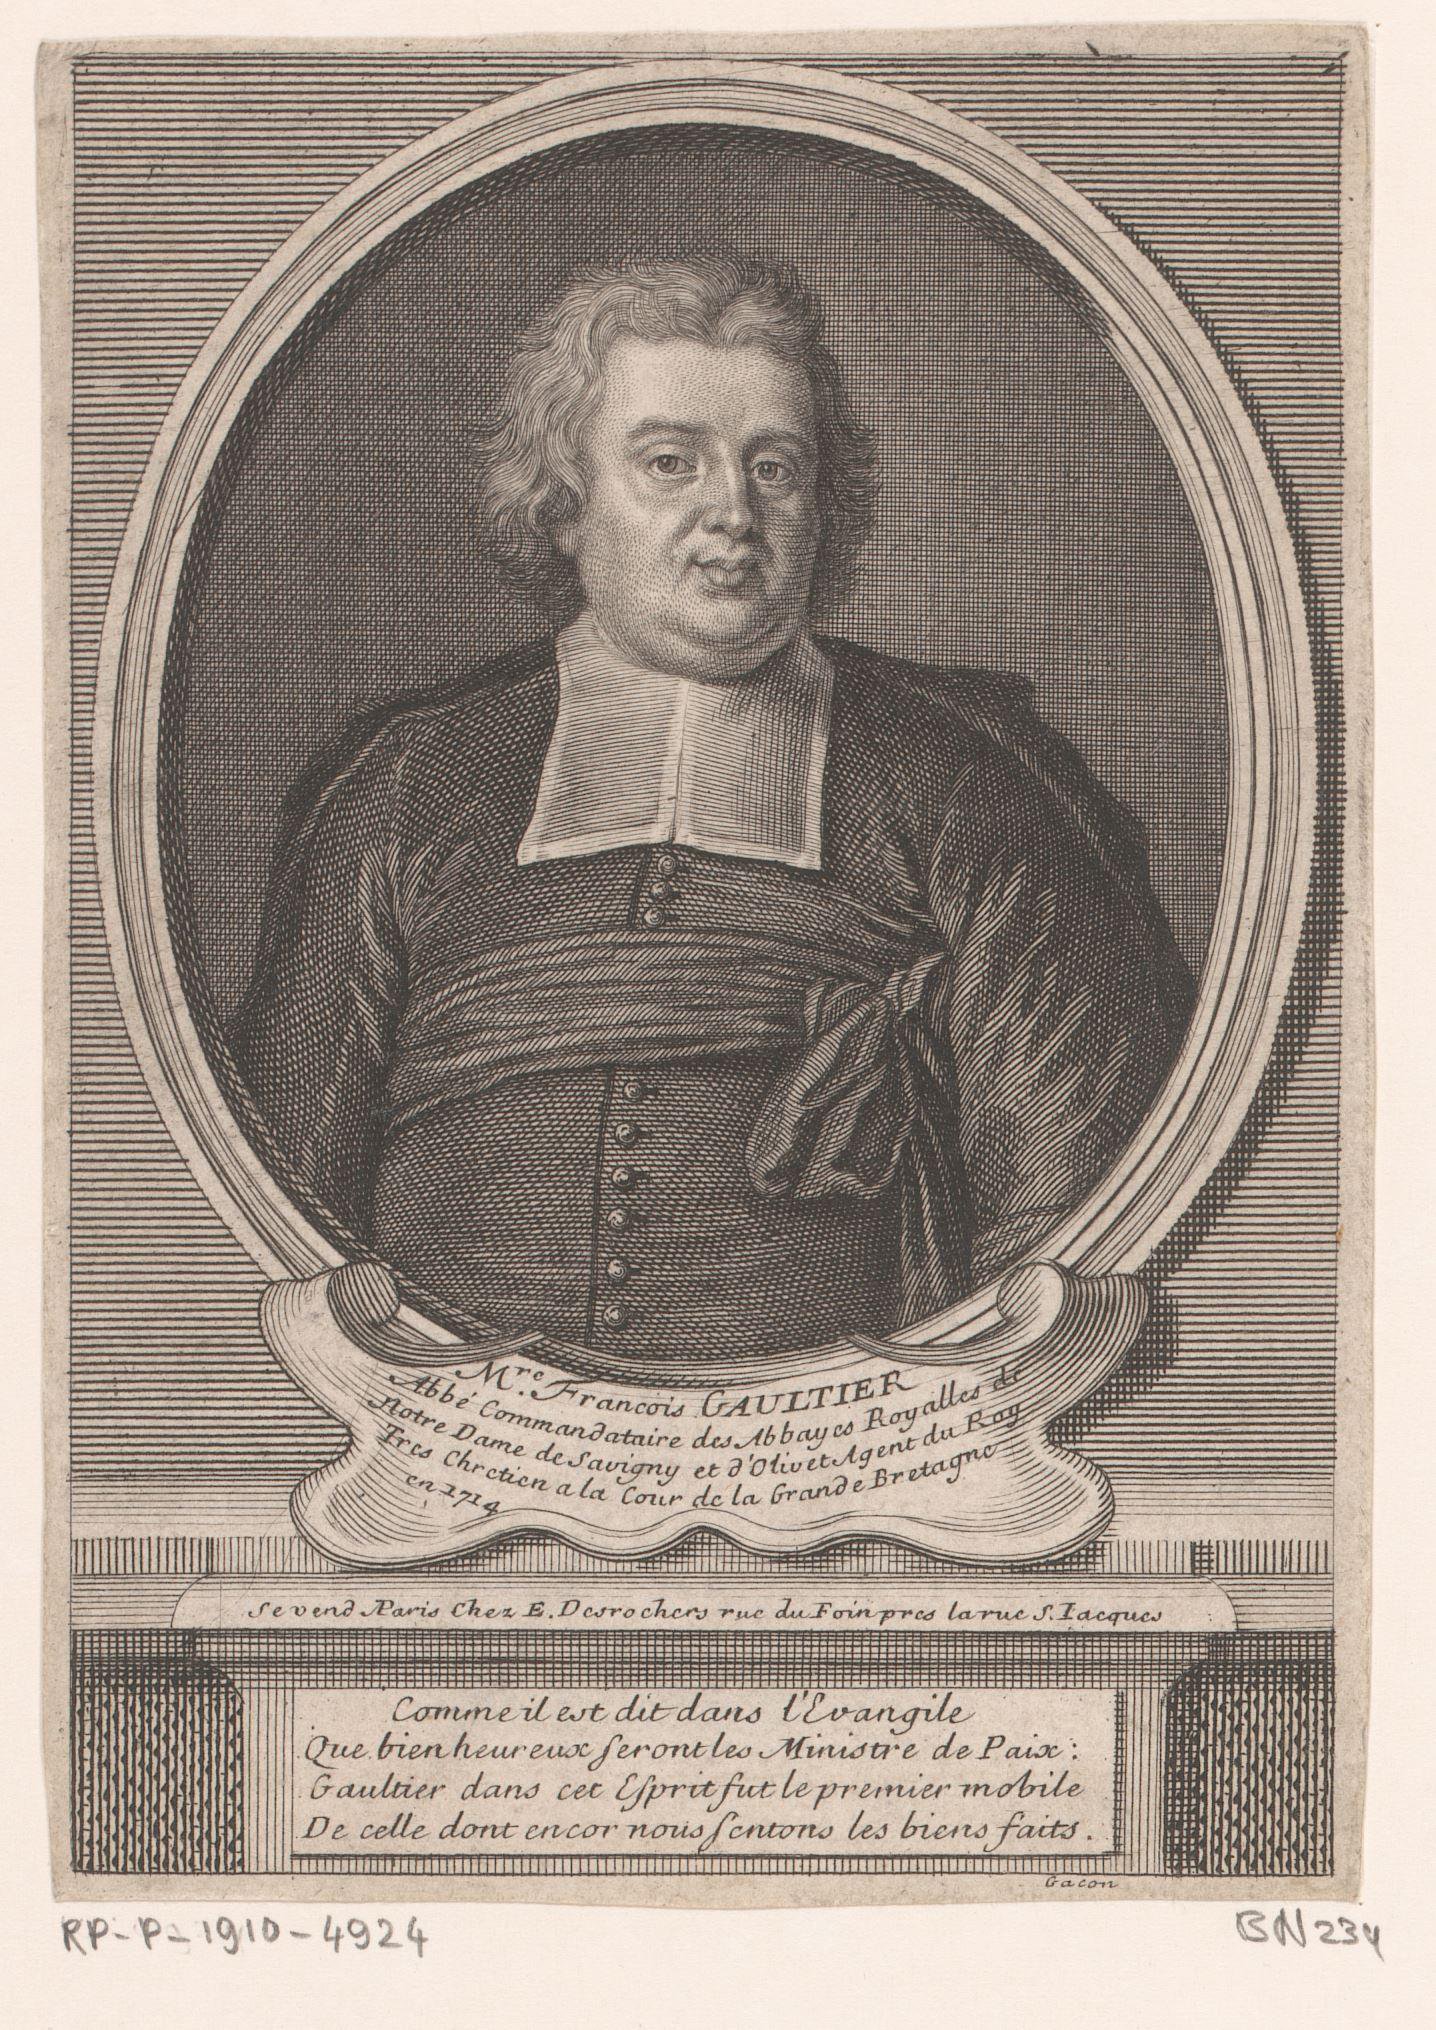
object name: print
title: Portret van François Gaultier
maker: étienne desrochers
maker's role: print maker, publisher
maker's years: 1668-1741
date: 1726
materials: paper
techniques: engraving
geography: paris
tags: clergyman, historical persons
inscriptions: collector's mark: Lugt 2228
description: Behoort waarschijnlijk tot een serie portretten, grotendeels door Etienne Desrochers, getiteld: 'Recueil de portraits de personnes qui se sont distinguées tant dans les Armes que dans Belles-Lettres et les Arts, comme aussi la famille royale de France et autres cours étrangères'. De serie werd initieel uitgegeven door Desrochers en aangekondigd in 'Mercure' in mei 1726, p. 985. Echter was Desrochers reeds enkele jaren eerder begonnen met het uitgeven van de serie. Na de dood van Desrochers werd de serie voortgezet door Gilles Edme Petit. Een latere staat werd uitgegeven door Jean François Daumont in Parijs.